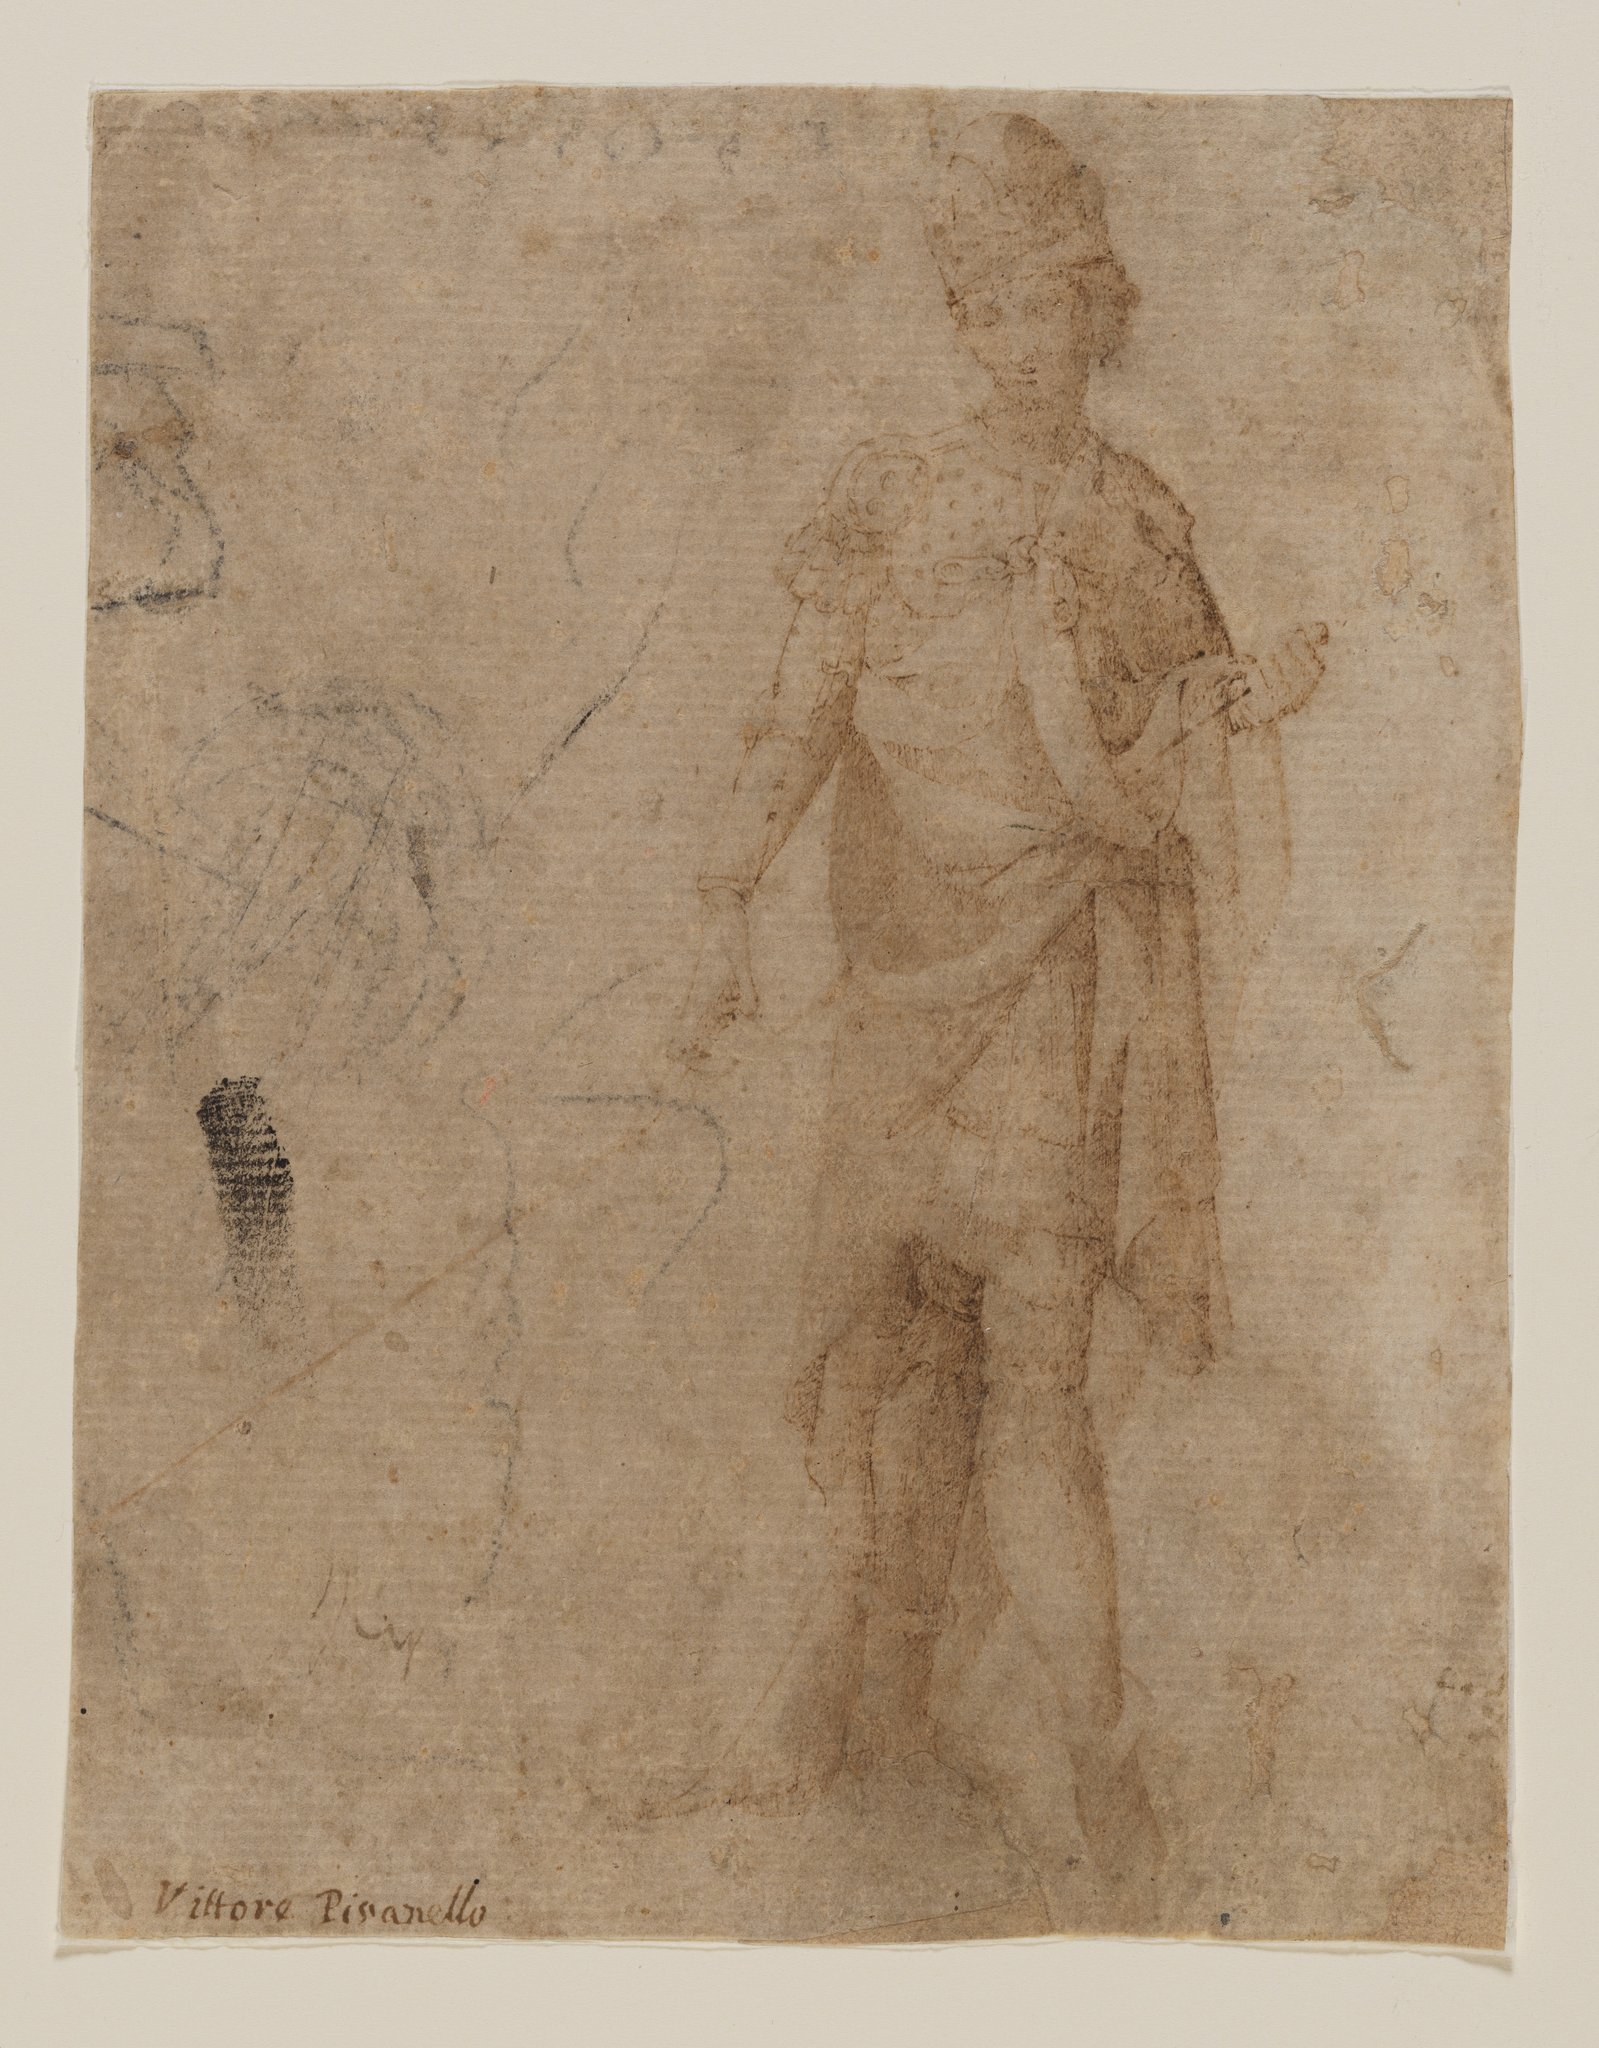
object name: drawing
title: A Young Man in Armor, Facing Front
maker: arcangelo di cola da camerino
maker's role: artist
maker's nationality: italian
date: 1425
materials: chalk, ink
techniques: pen, wash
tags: men